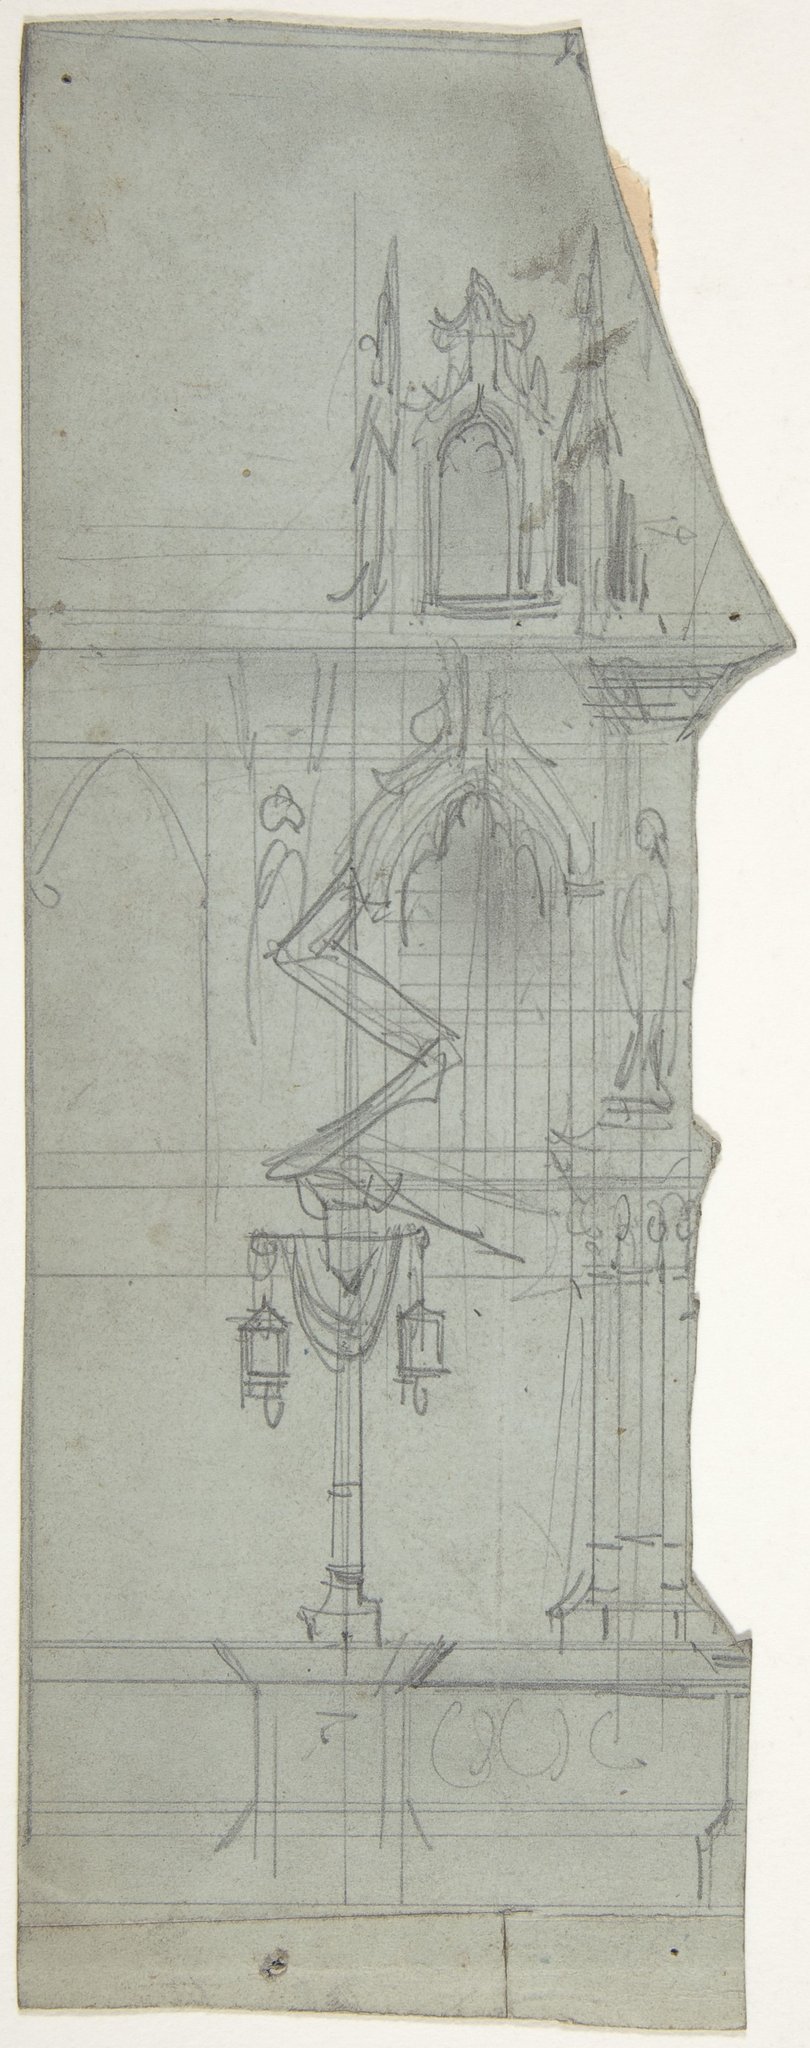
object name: drawing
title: Design for a Stage Set at the Opéra, Paris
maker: eugène cicéri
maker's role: artist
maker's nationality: french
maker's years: 1813-1890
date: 1830-1890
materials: graphite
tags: stage design